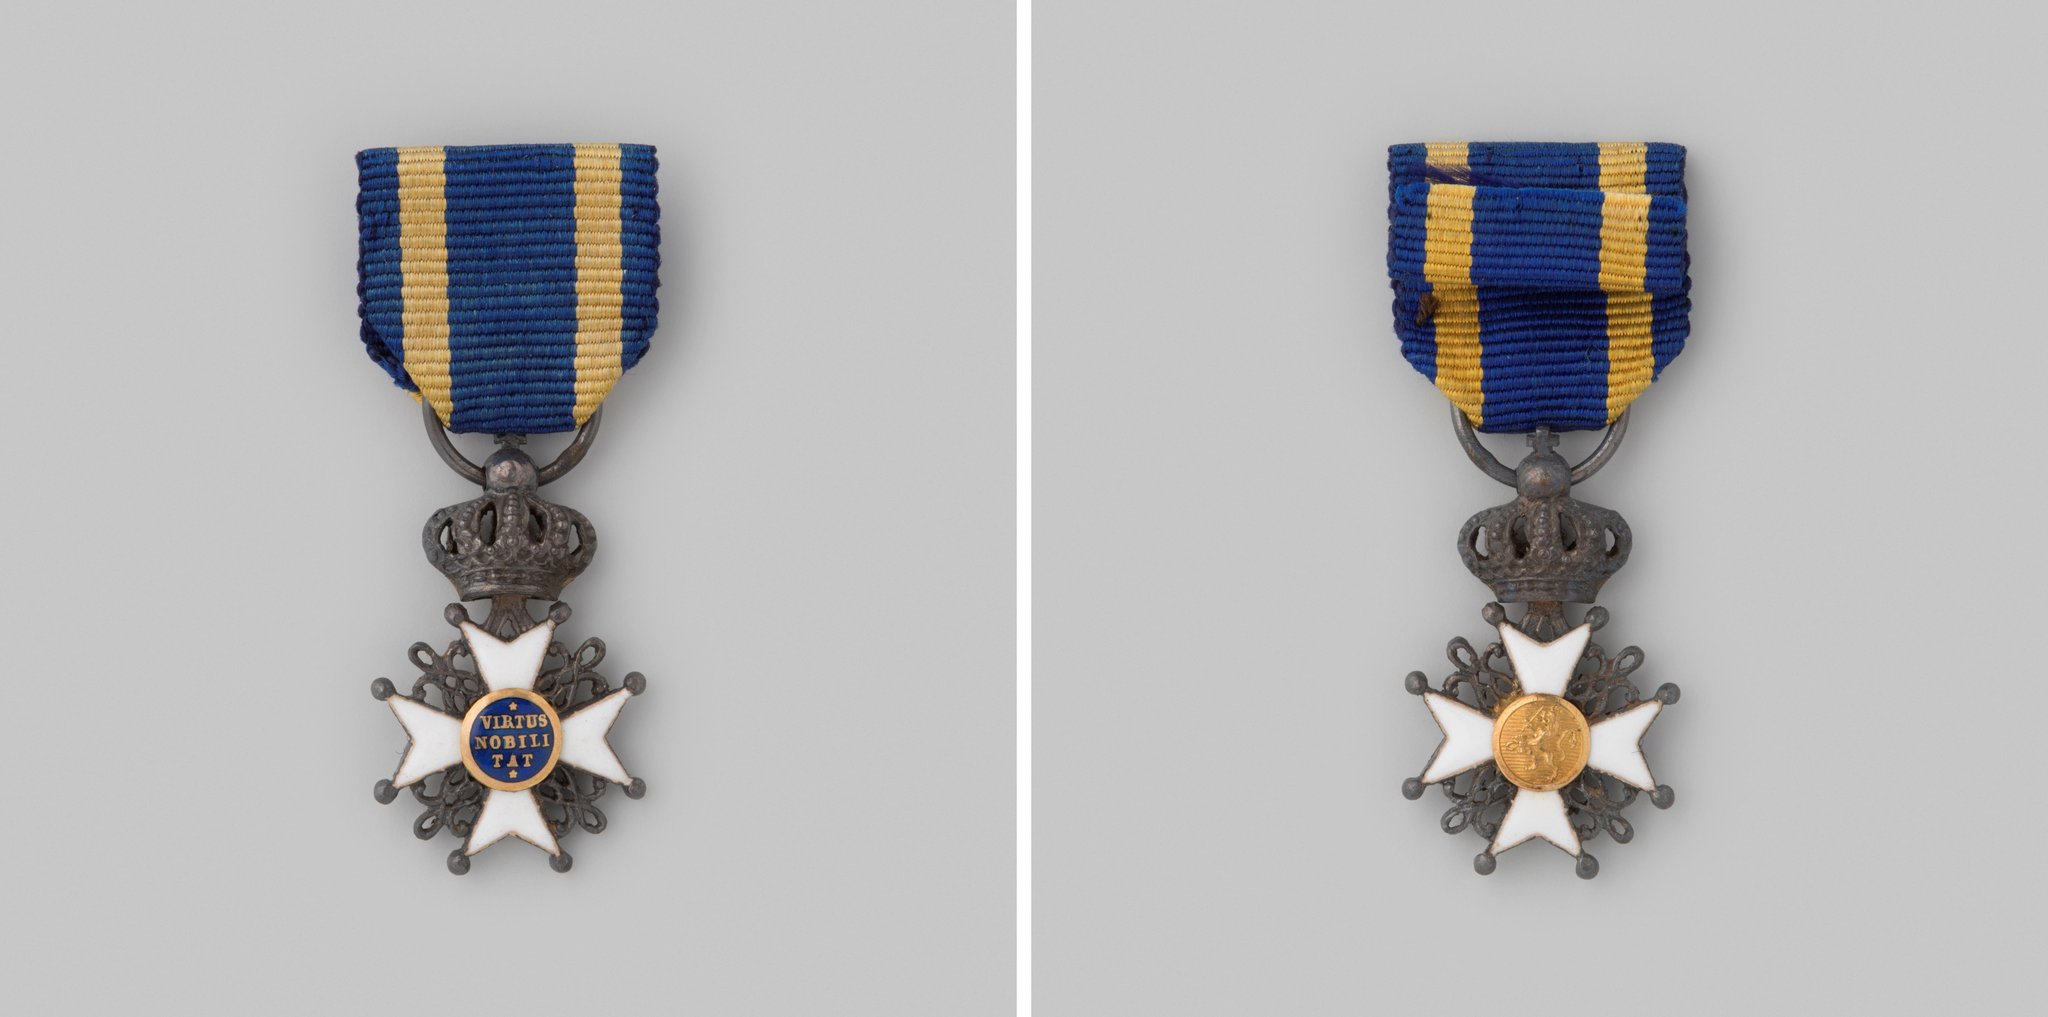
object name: insignia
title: Ridderkruis van de orde van de Nederlandse Leeuw, virtus nobilitat, gedragen door Mr. W.K. van der Breggen, lid van de schuttersraad te Amsterdam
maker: Anonymous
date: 1815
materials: silver, textile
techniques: gilding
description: Zilveren draagpenning met email, verguldsel, knop, ring en lint.